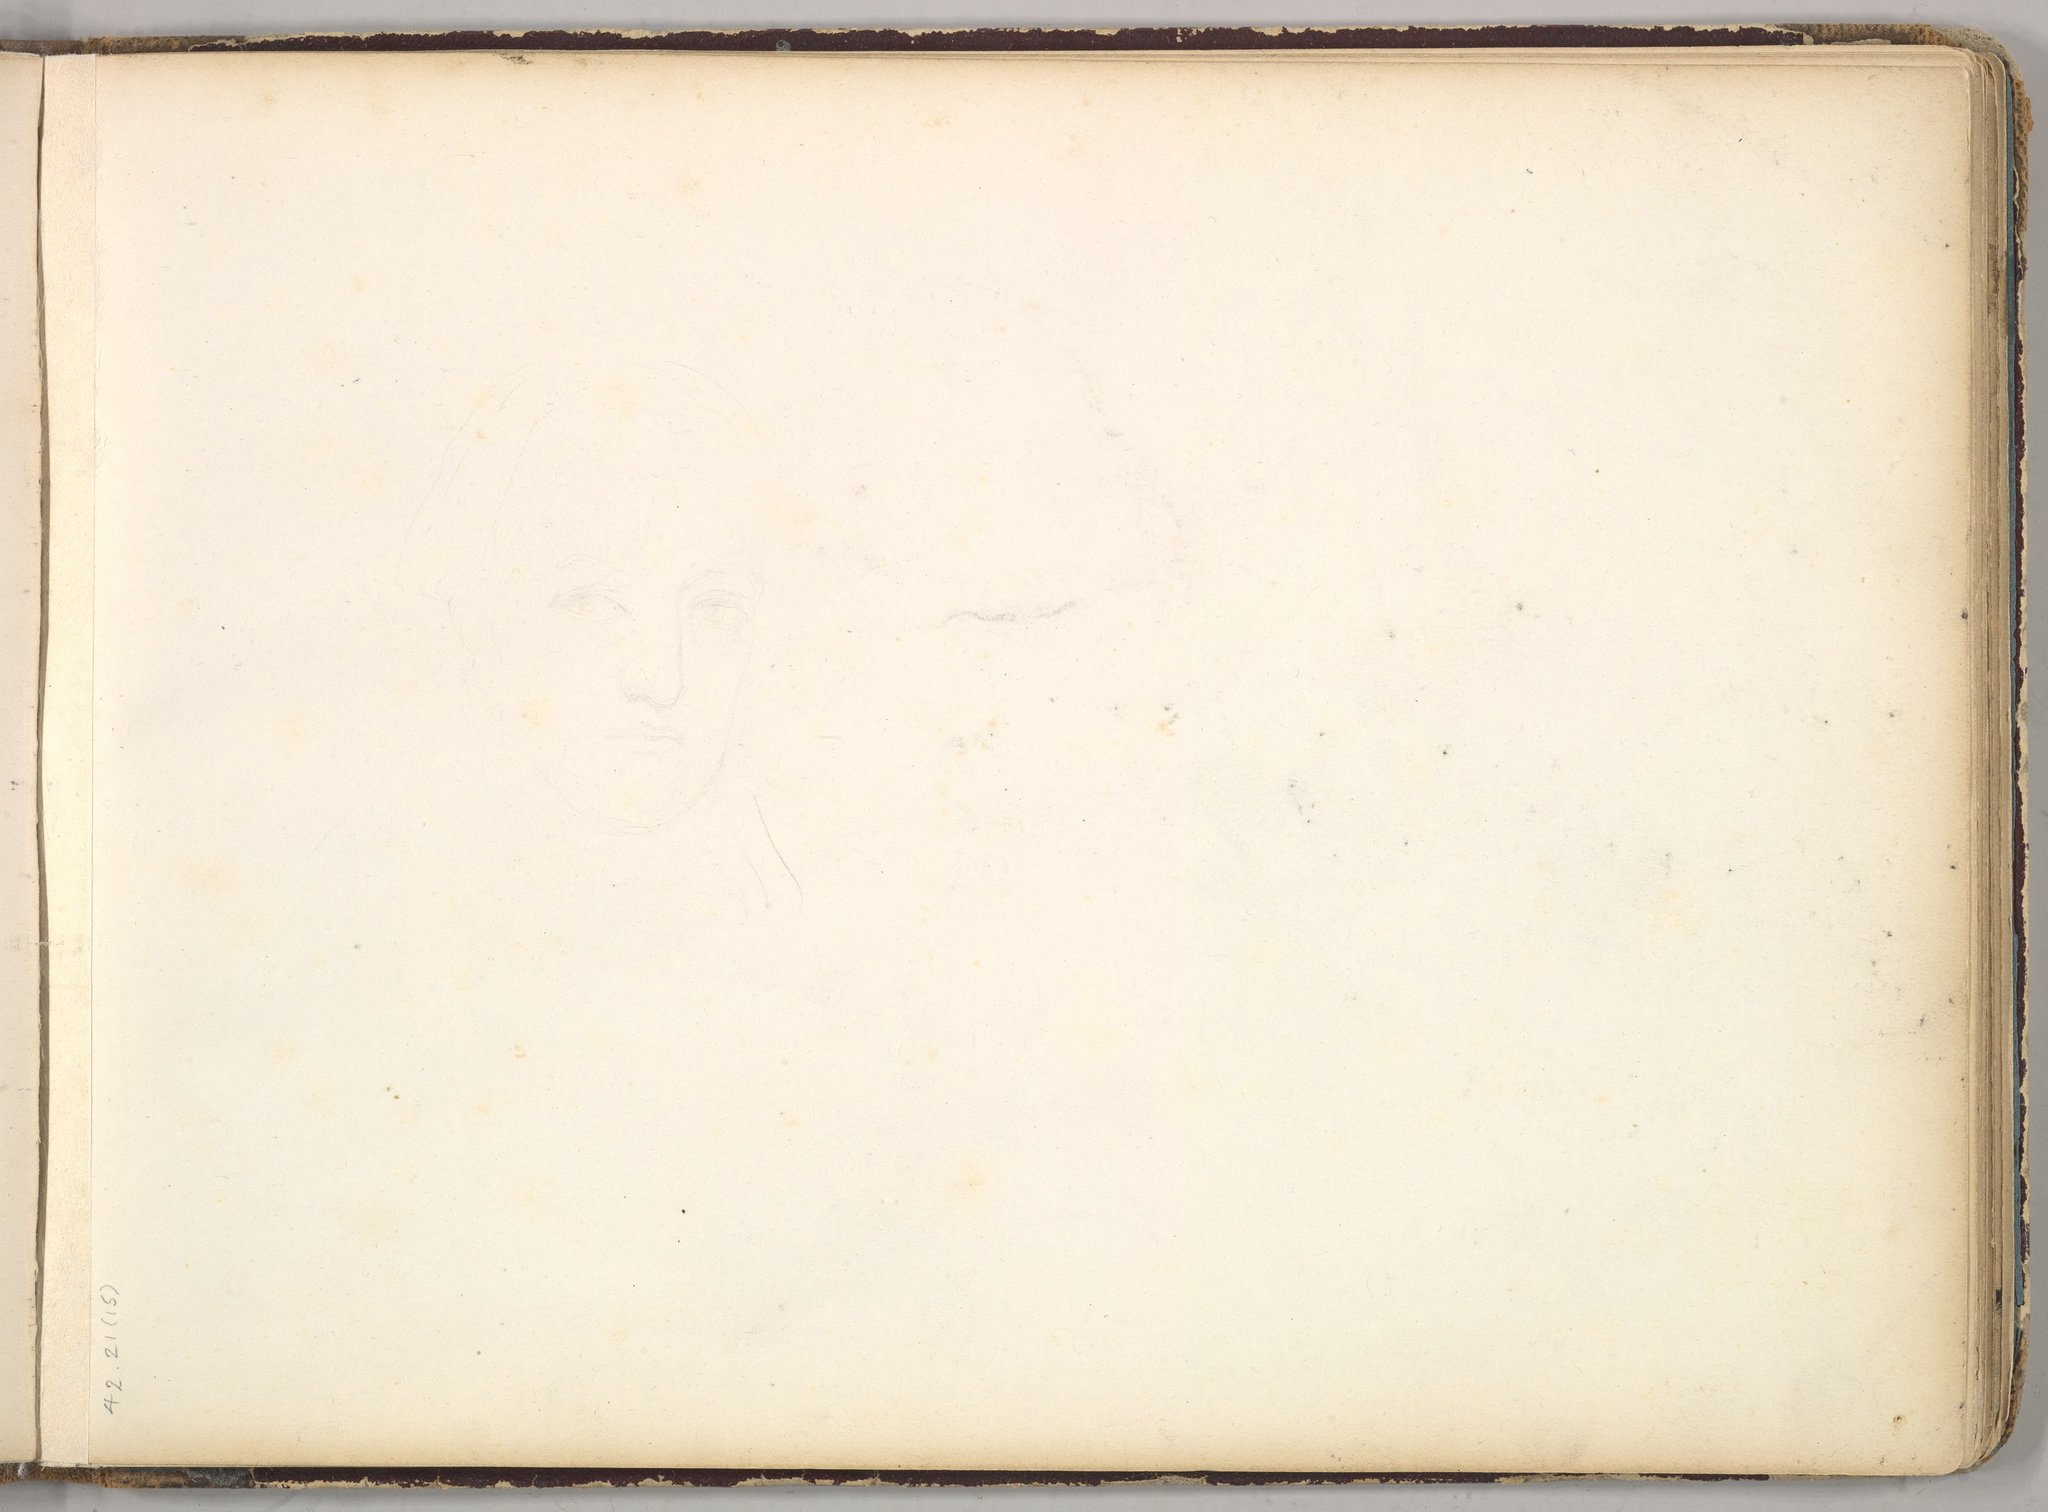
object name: drawing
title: A Man's Head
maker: frederic, lord leighton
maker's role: artist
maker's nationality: british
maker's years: 1830-1896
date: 1849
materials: graphite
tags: heads,men